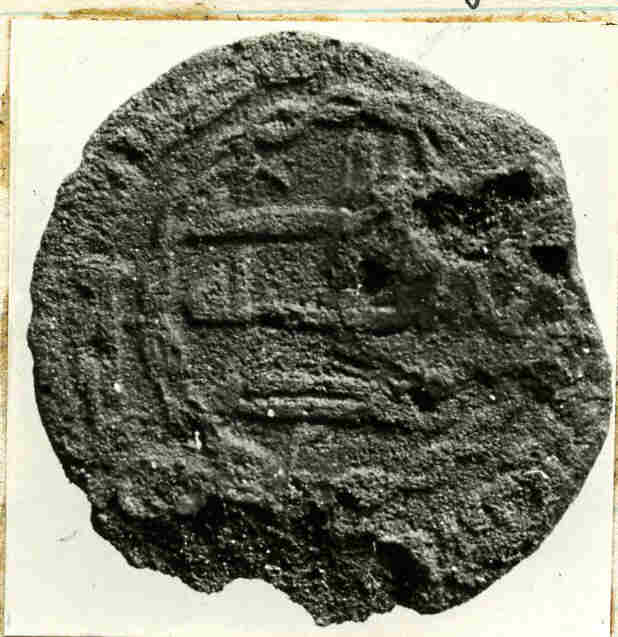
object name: coin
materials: copper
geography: iran